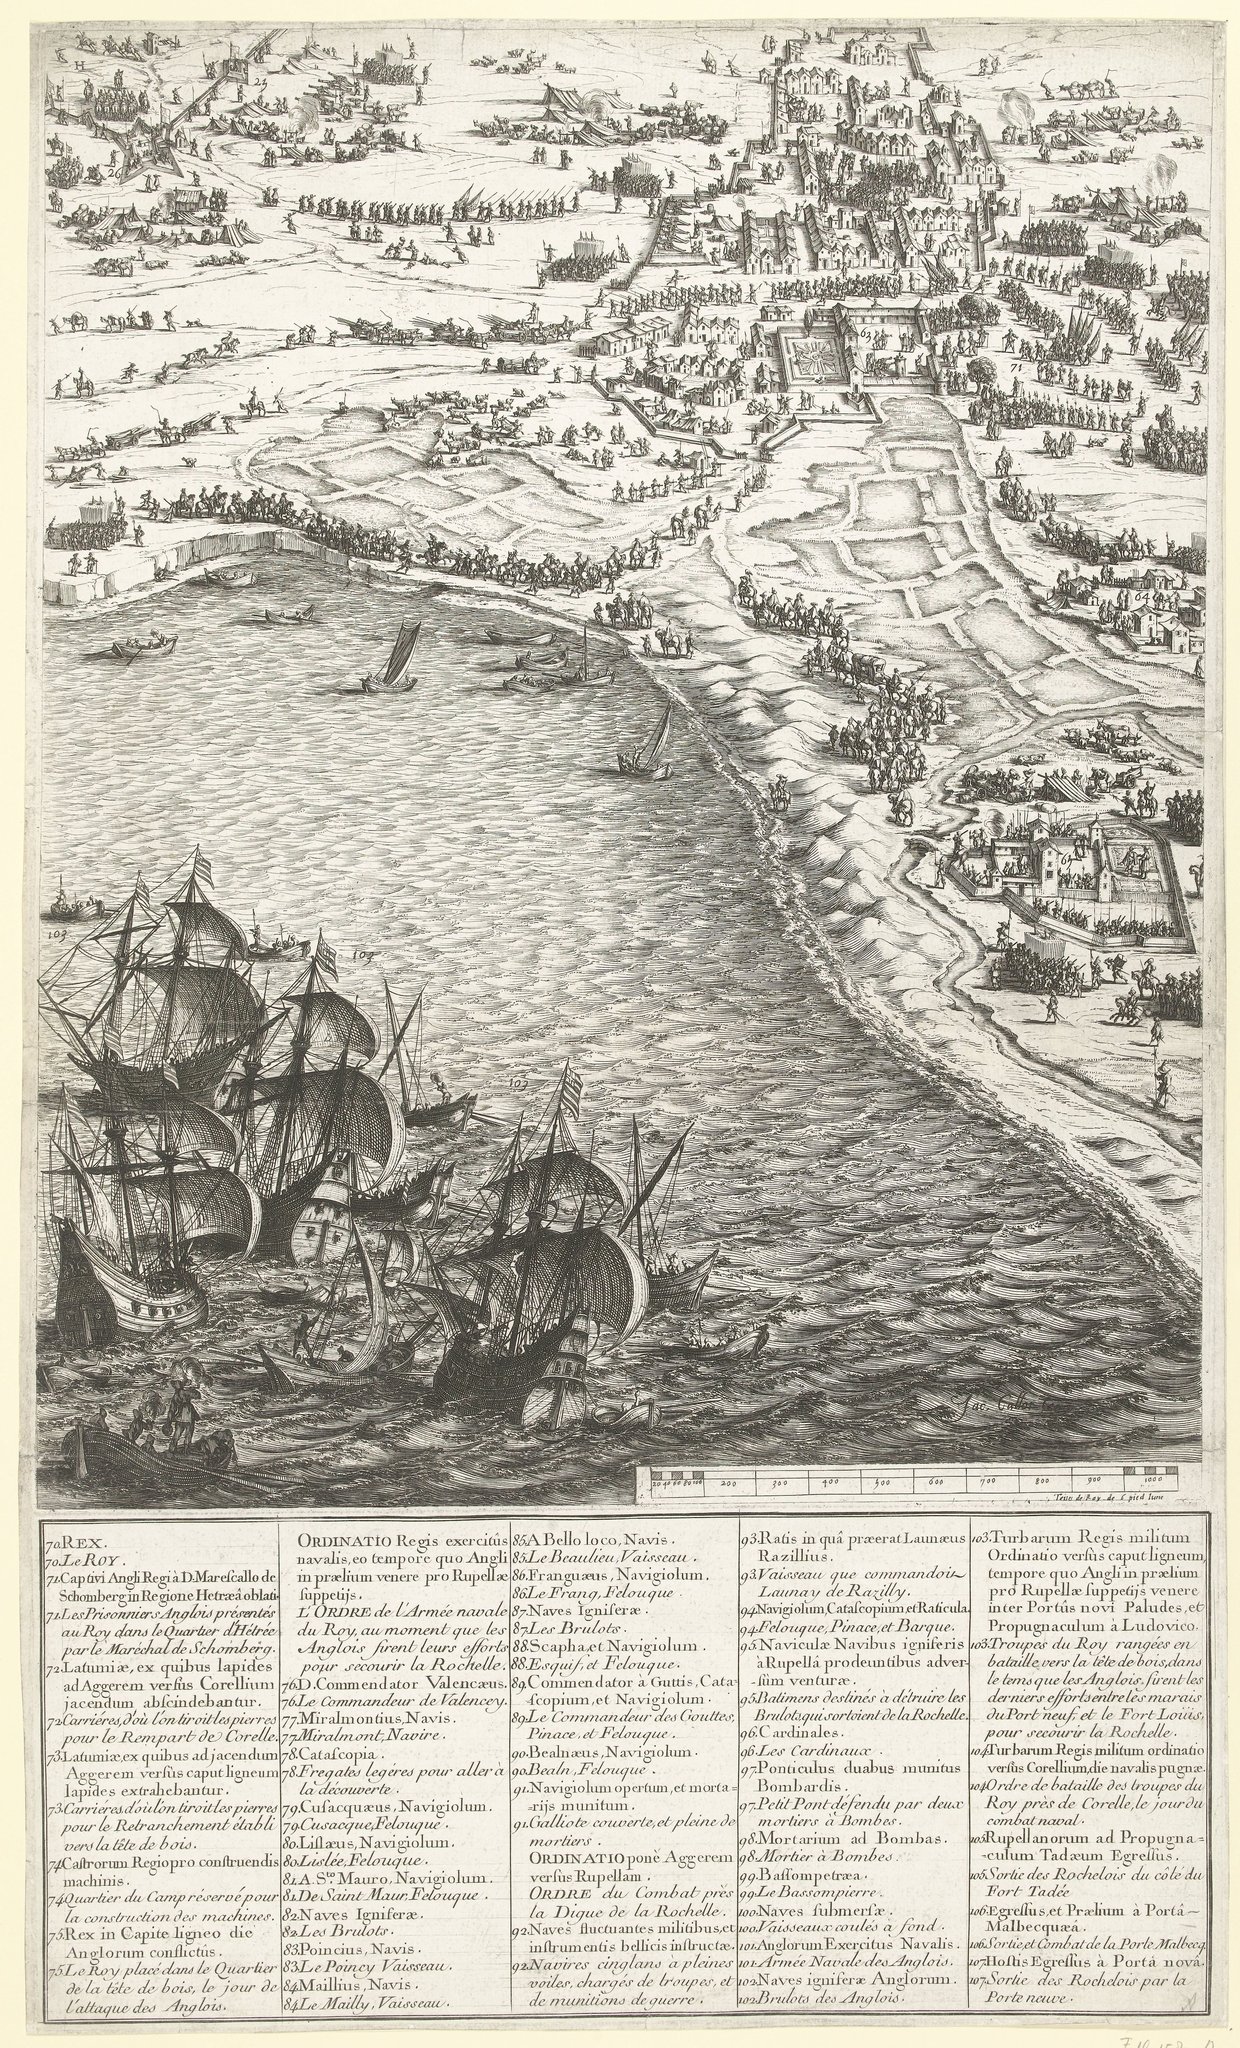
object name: print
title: Beleg van La Rochelle, september 1627-oktober 1628 (centrale kaart, deel rechtsonder)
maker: jacques callot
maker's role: draughtsman, print maker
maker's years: 1592-1635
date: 1628-1631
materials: paper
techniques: etching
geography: paris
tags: maps of separate countries or regions, ships (in general), warfare; military affairs (+ naval force), siege, temporary fortifications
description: Grote prent van het beleg van het hugenotenbolwerk La Rochelle in de jaren 1627 en 1628, dat werd uitgevoerd in opdracht van de Franse koning door het Franse leger onder aanvoering van kardinaal Richelieu. Centrale kaart, deel rechtsonder. Op dit blad een deel van het gebied om La Rochelle heen, bevolkt door vele figuurtjes. Hier en daar zijn belegeringswerken (schansen, versterkingen, wallen e.d.) herkenbaar. Op de voorgrond enkele schepen voor de kust. Rechtsonder een schaalaanduiding. Op een aparte plaat onder de voorstelling de legenda 70-107 in 5 kolommen in het Frans.